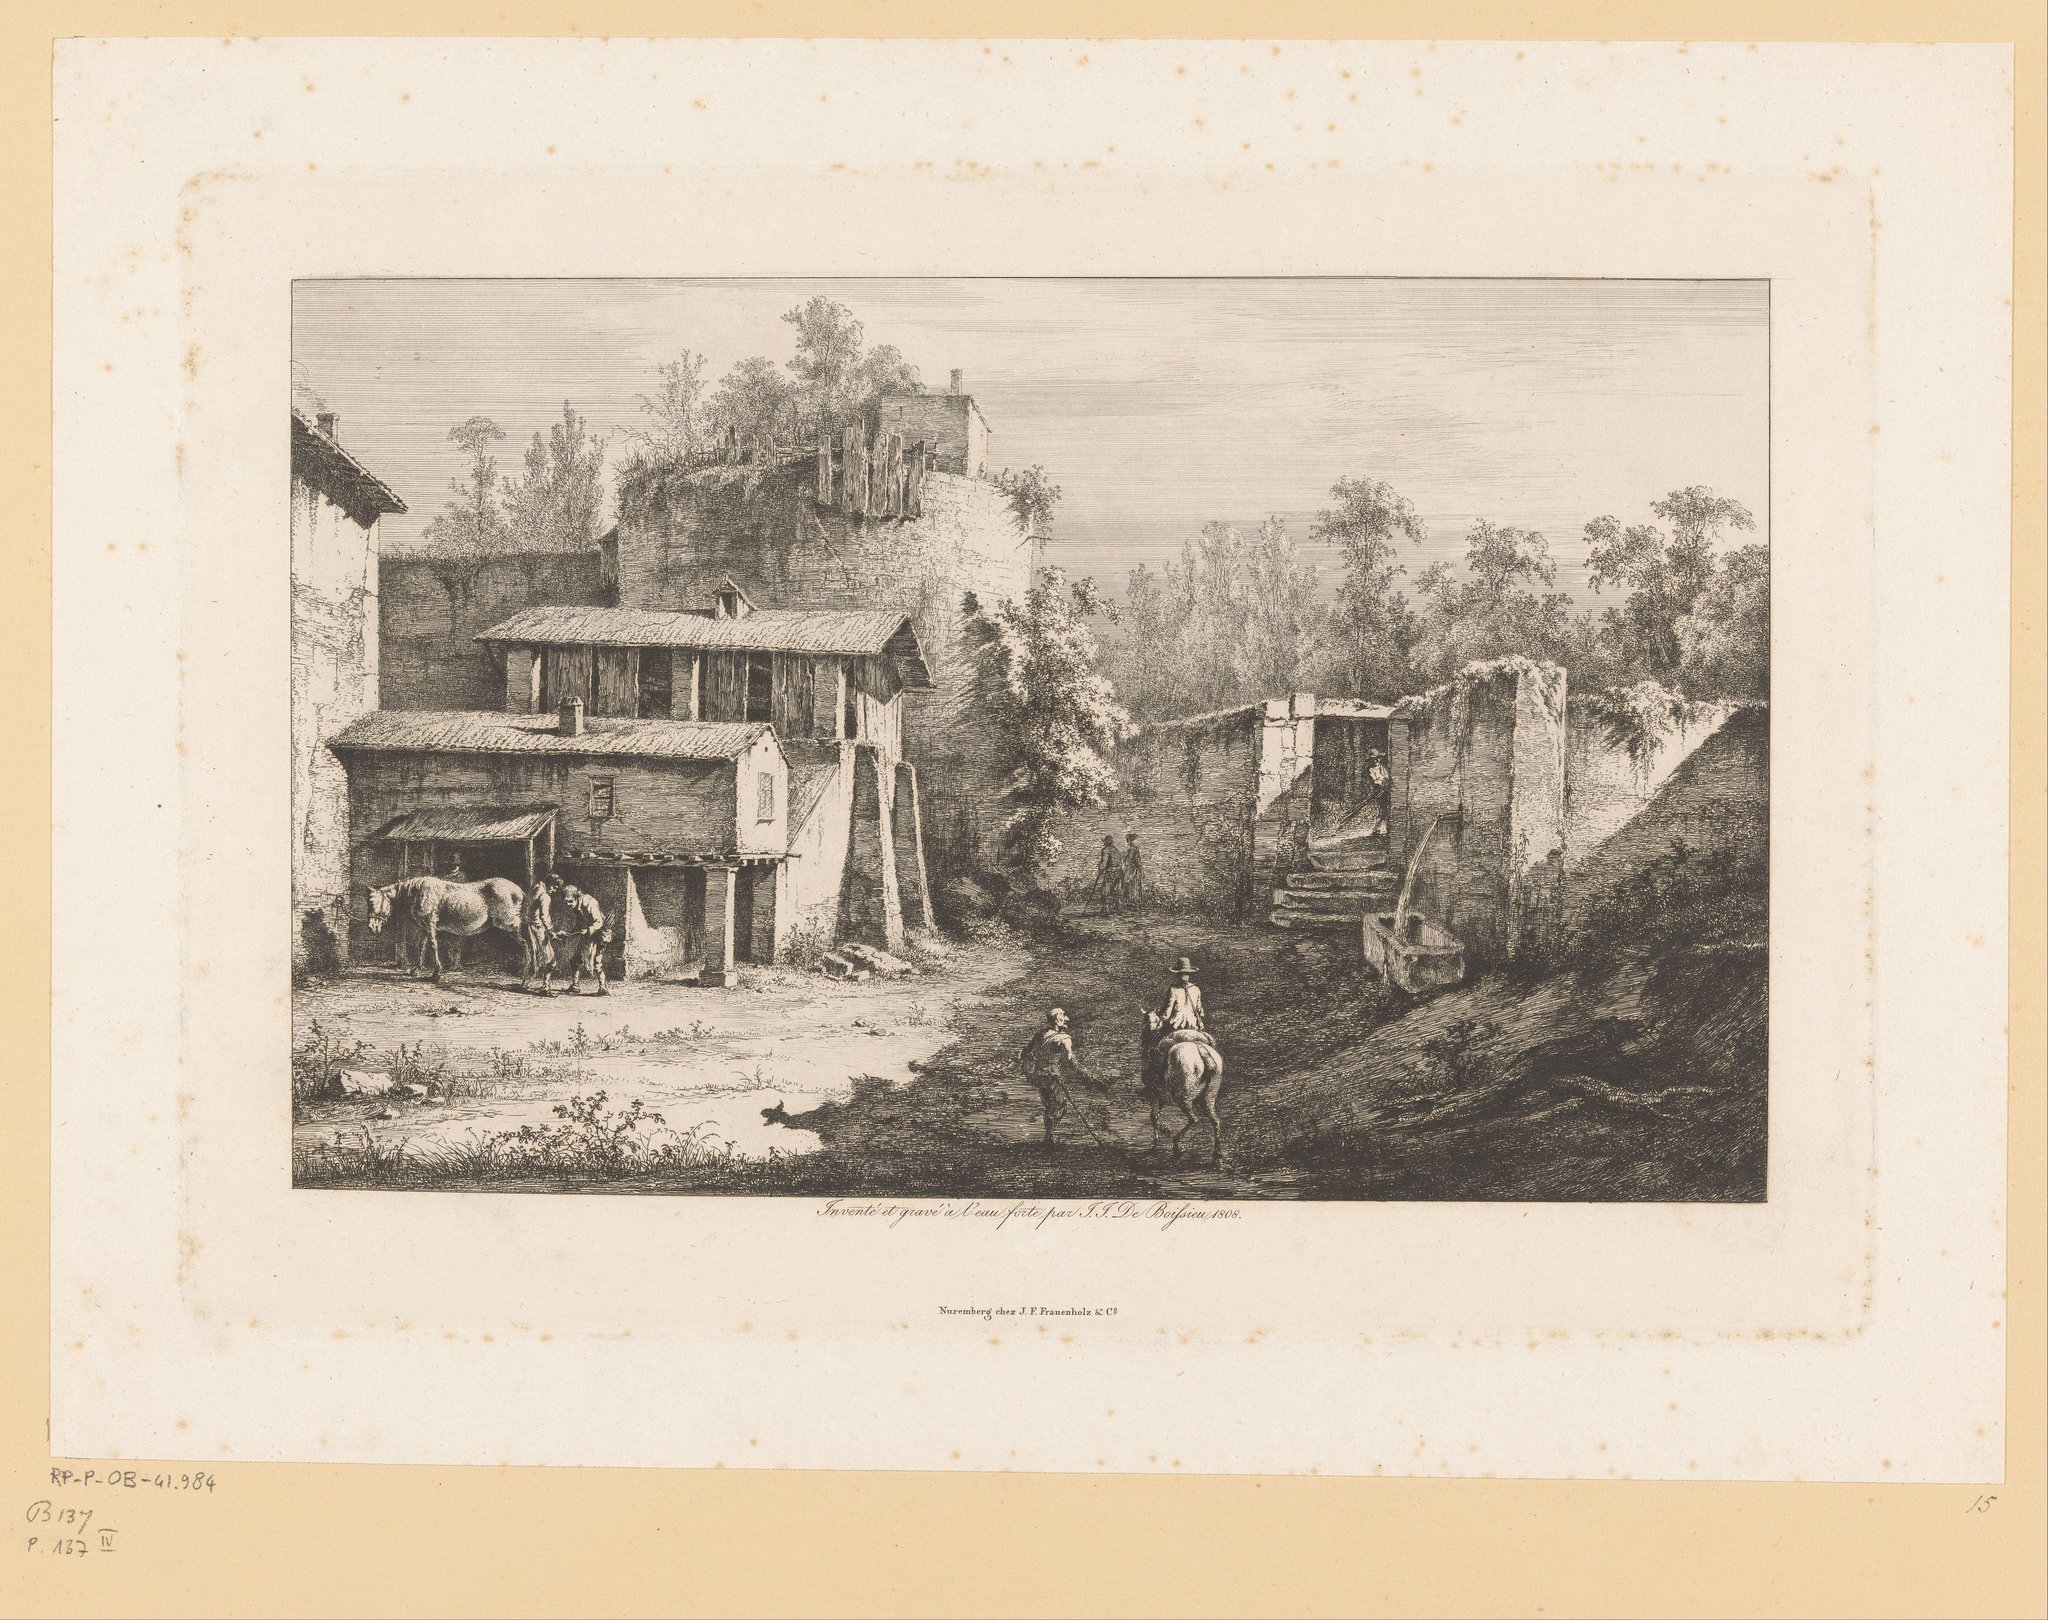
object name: print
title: Hoefsmid te Terrebasse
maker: jean jacques de boissieu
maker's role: draughtsman, print maker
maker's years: 1736-1810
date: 1808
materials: paper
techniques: drypoint, etching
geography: france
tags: farrier, shoeing-smith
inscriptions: collector's mark: Lugt 12